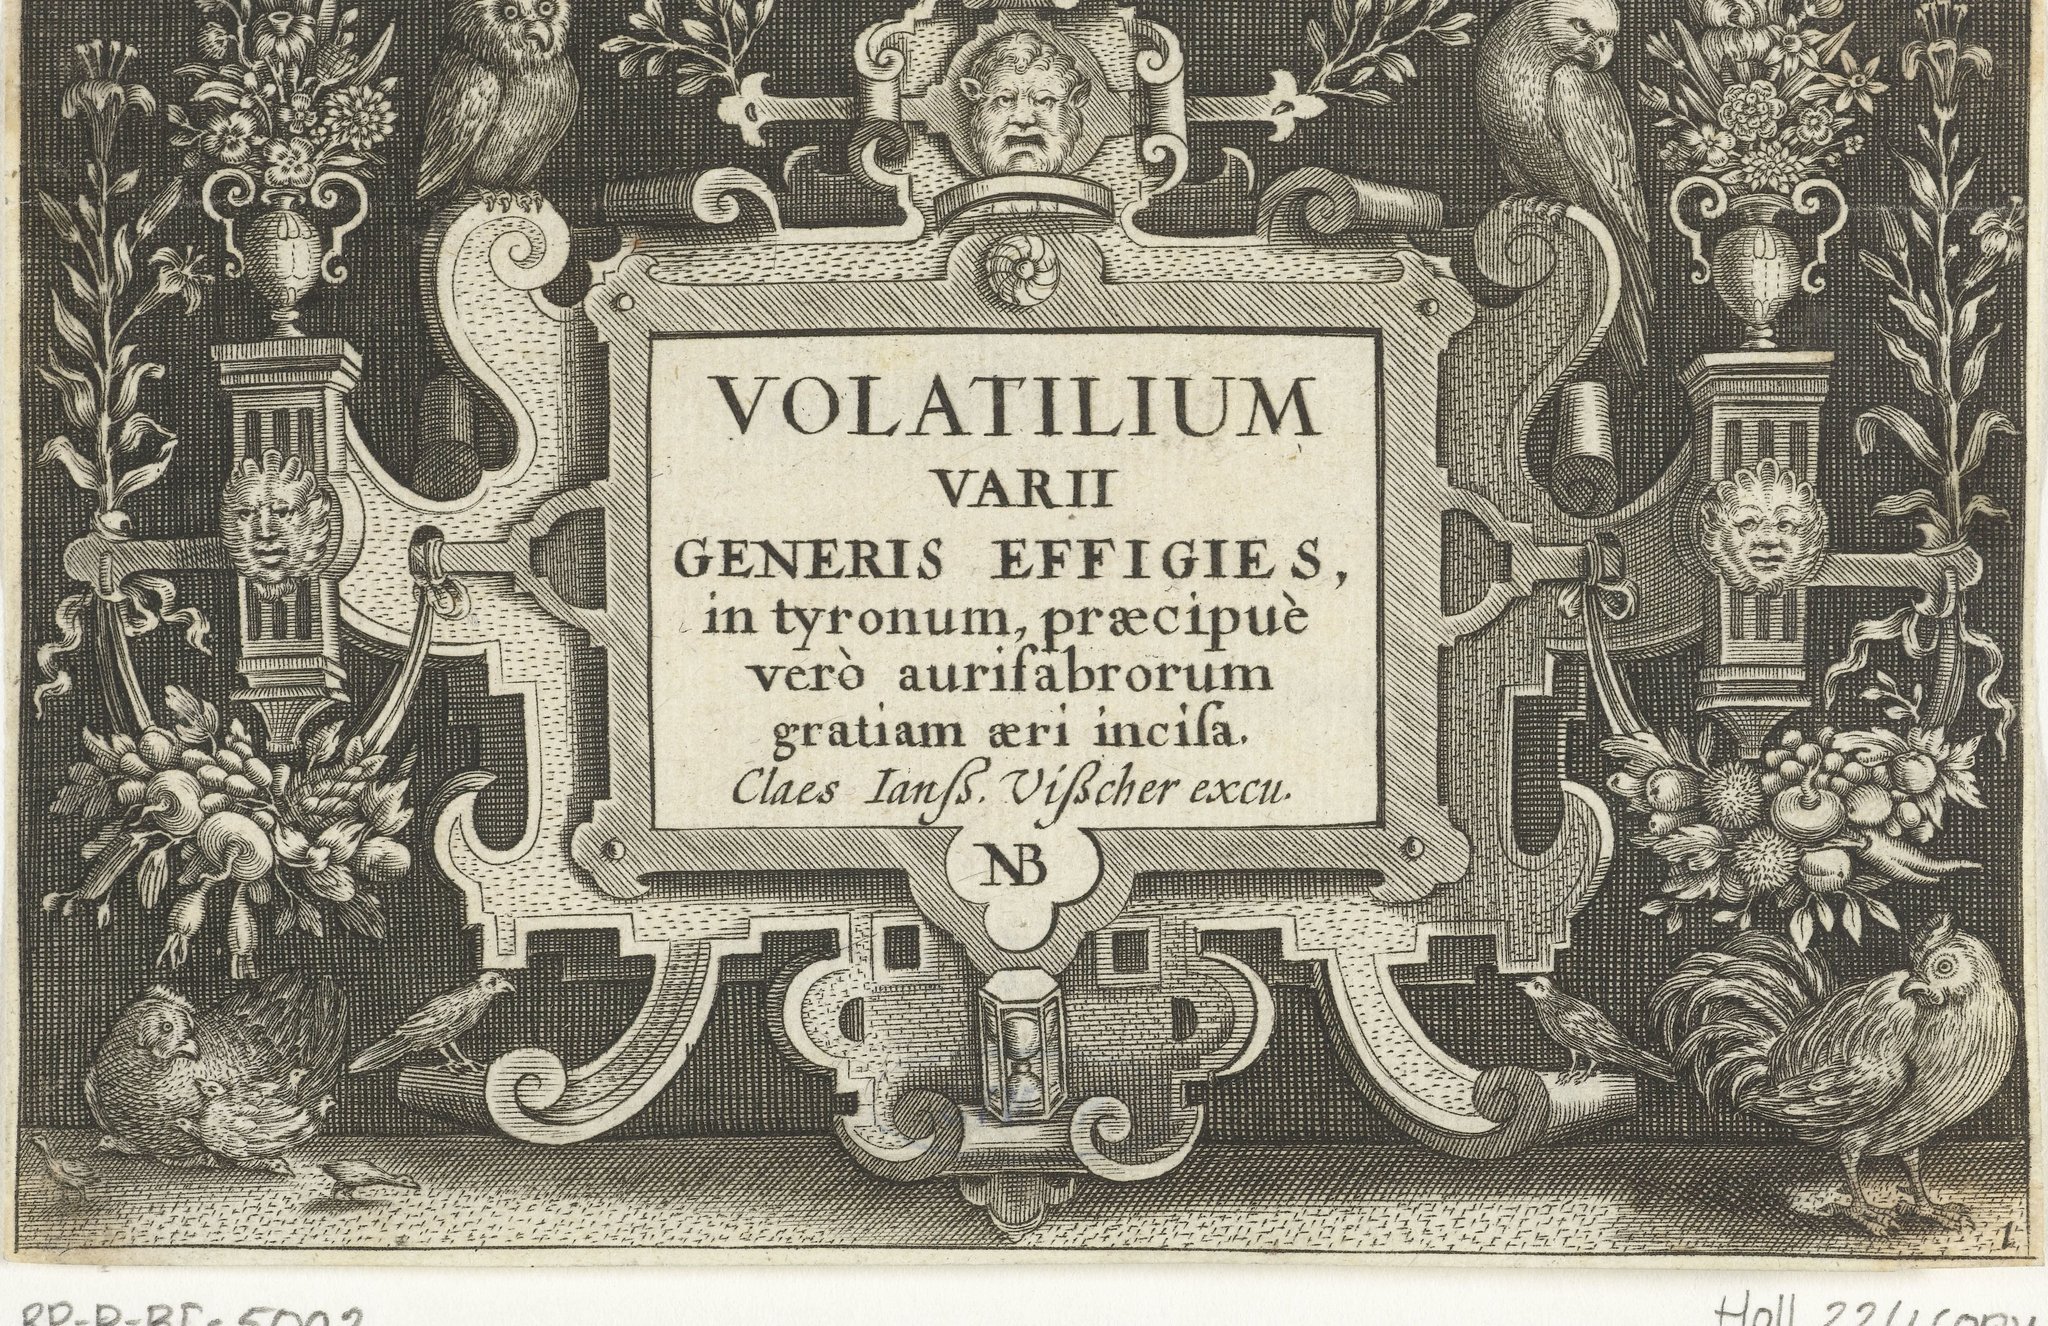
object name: print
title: Vogels en insecten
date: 1594-1644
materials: paper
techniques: engraving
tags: birds, ornament ~ cartouche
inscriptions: collector's mark: Lugt 2228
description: Titelprent met titel in cartouche met ornamenten zoals guirlandes en bloemvazen. Vogels waaronder papegaai en uil zitten op het rolwerk. Onder een haan en hen met kuikens.